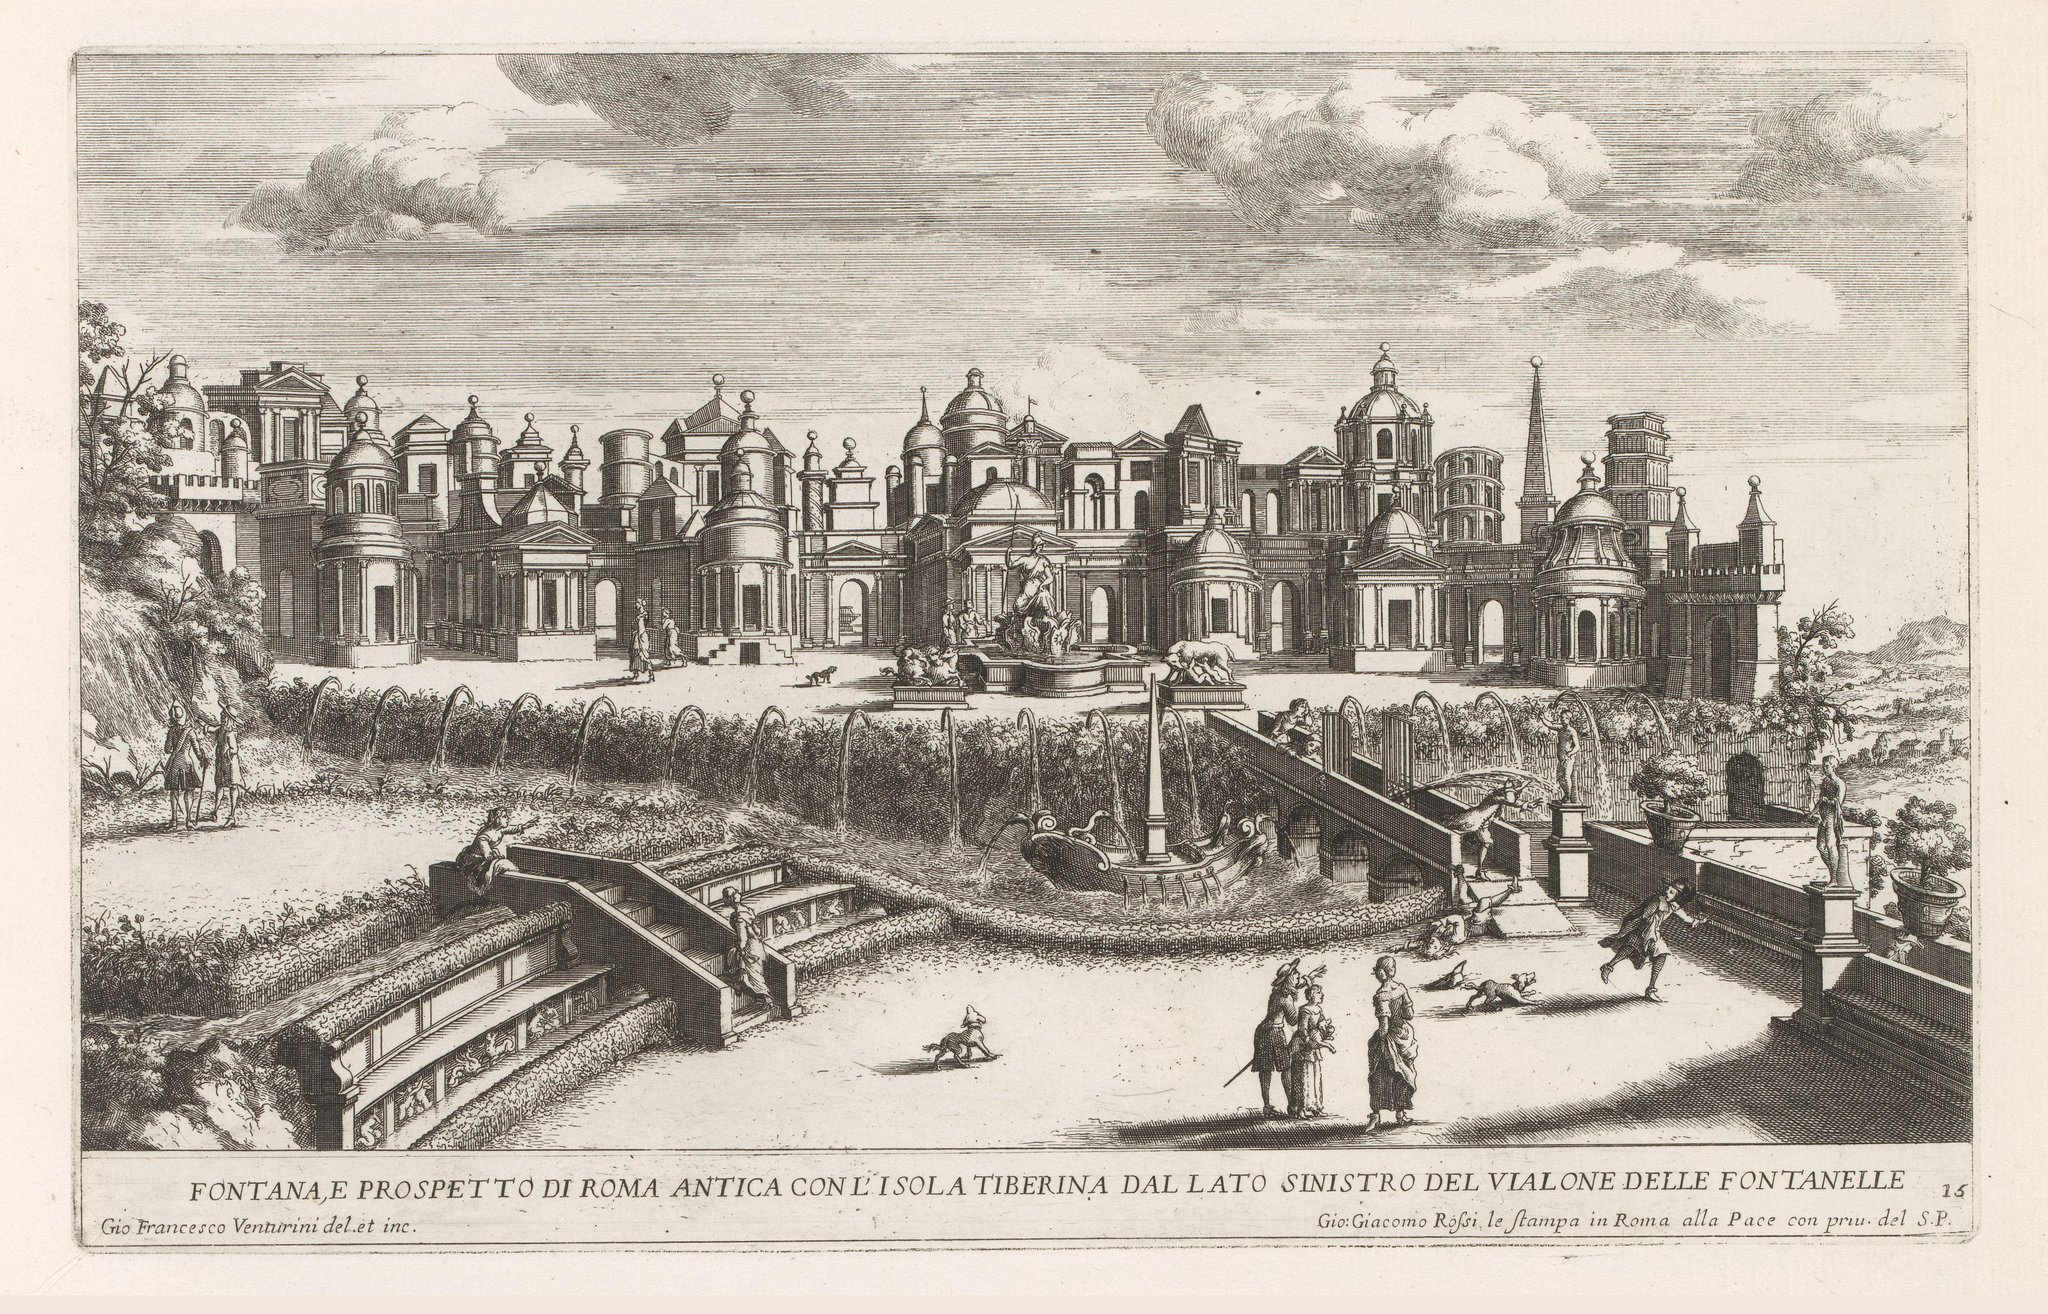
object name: album leaf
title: Fontana e prospetto di Roma antica con l'isola Tiberina dal lato sinistro (...)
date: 1653-1691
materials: paper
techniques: etching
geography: rome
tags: ornamental fountain, tivoli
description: Fontein van het Kleine Rome (Fontana della Rometta) met een bootvormige fontein met obelisk die het Tibereiland representeert. Aan de overkant van het water een fontein met een personificatie van Rome met links de antieke sculptuur van een paard en leeuw in gevecht en rechts Romulus en Remus met de wolvin. Daarachter verscheidene Romeinse gebouwen. Genummerd rechtsonder: 15. De prent maakt deel uit van een album.